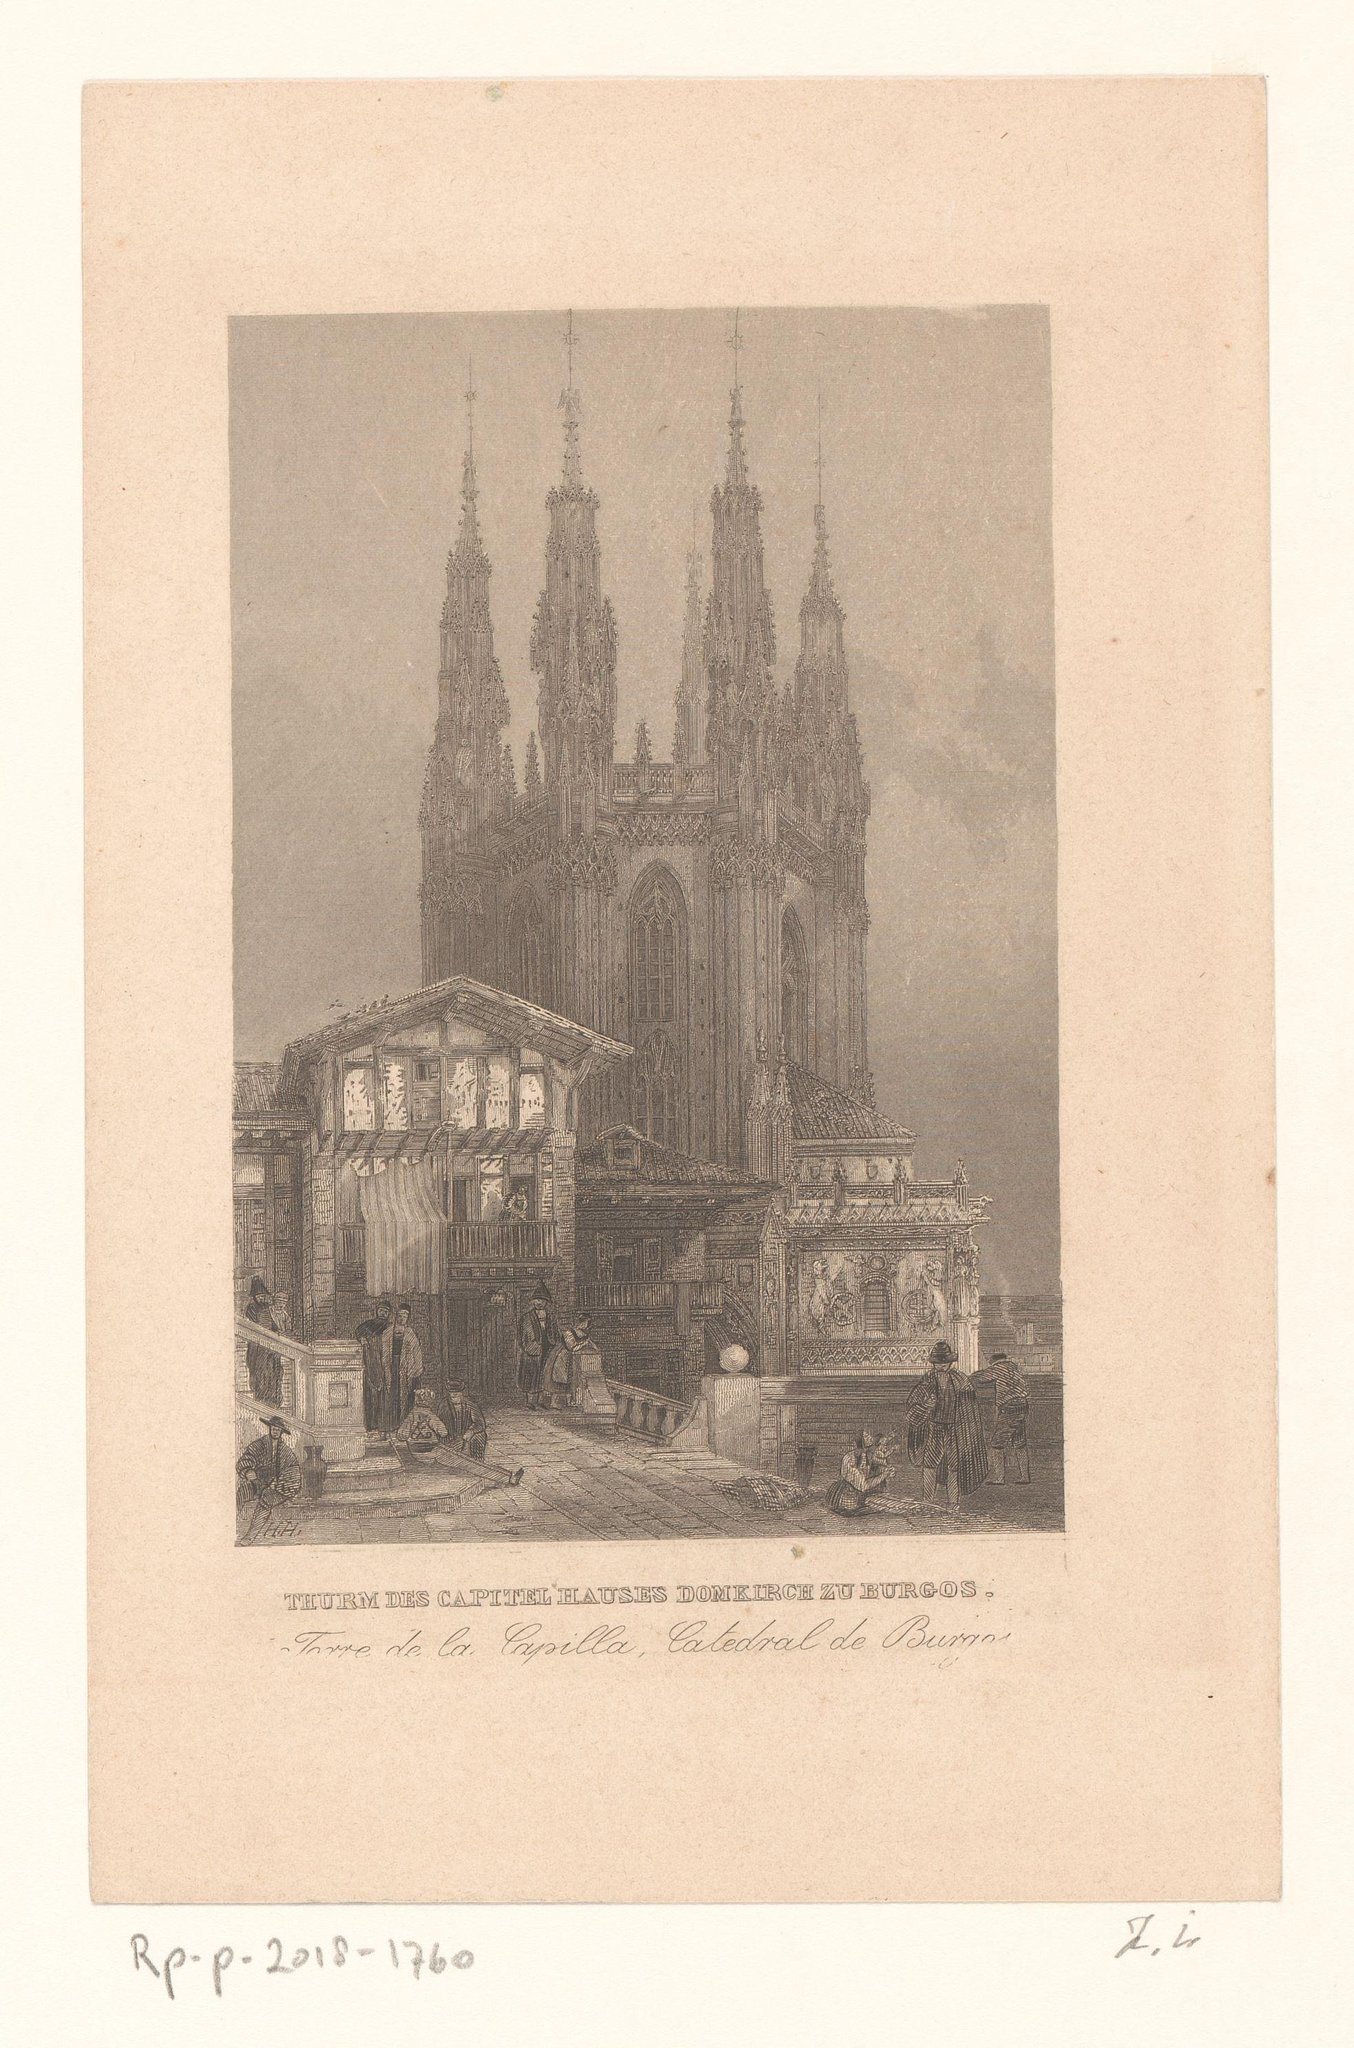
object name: print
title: Thurm des capitelhauses domkirche zu Burgos / Terre de la capilla, catedral de Burgos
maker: monogrammist hh (prentmaker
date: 1800-1899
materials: paper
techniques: engraving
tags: church (exterior)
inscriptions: collector's mark: Lugt 2228